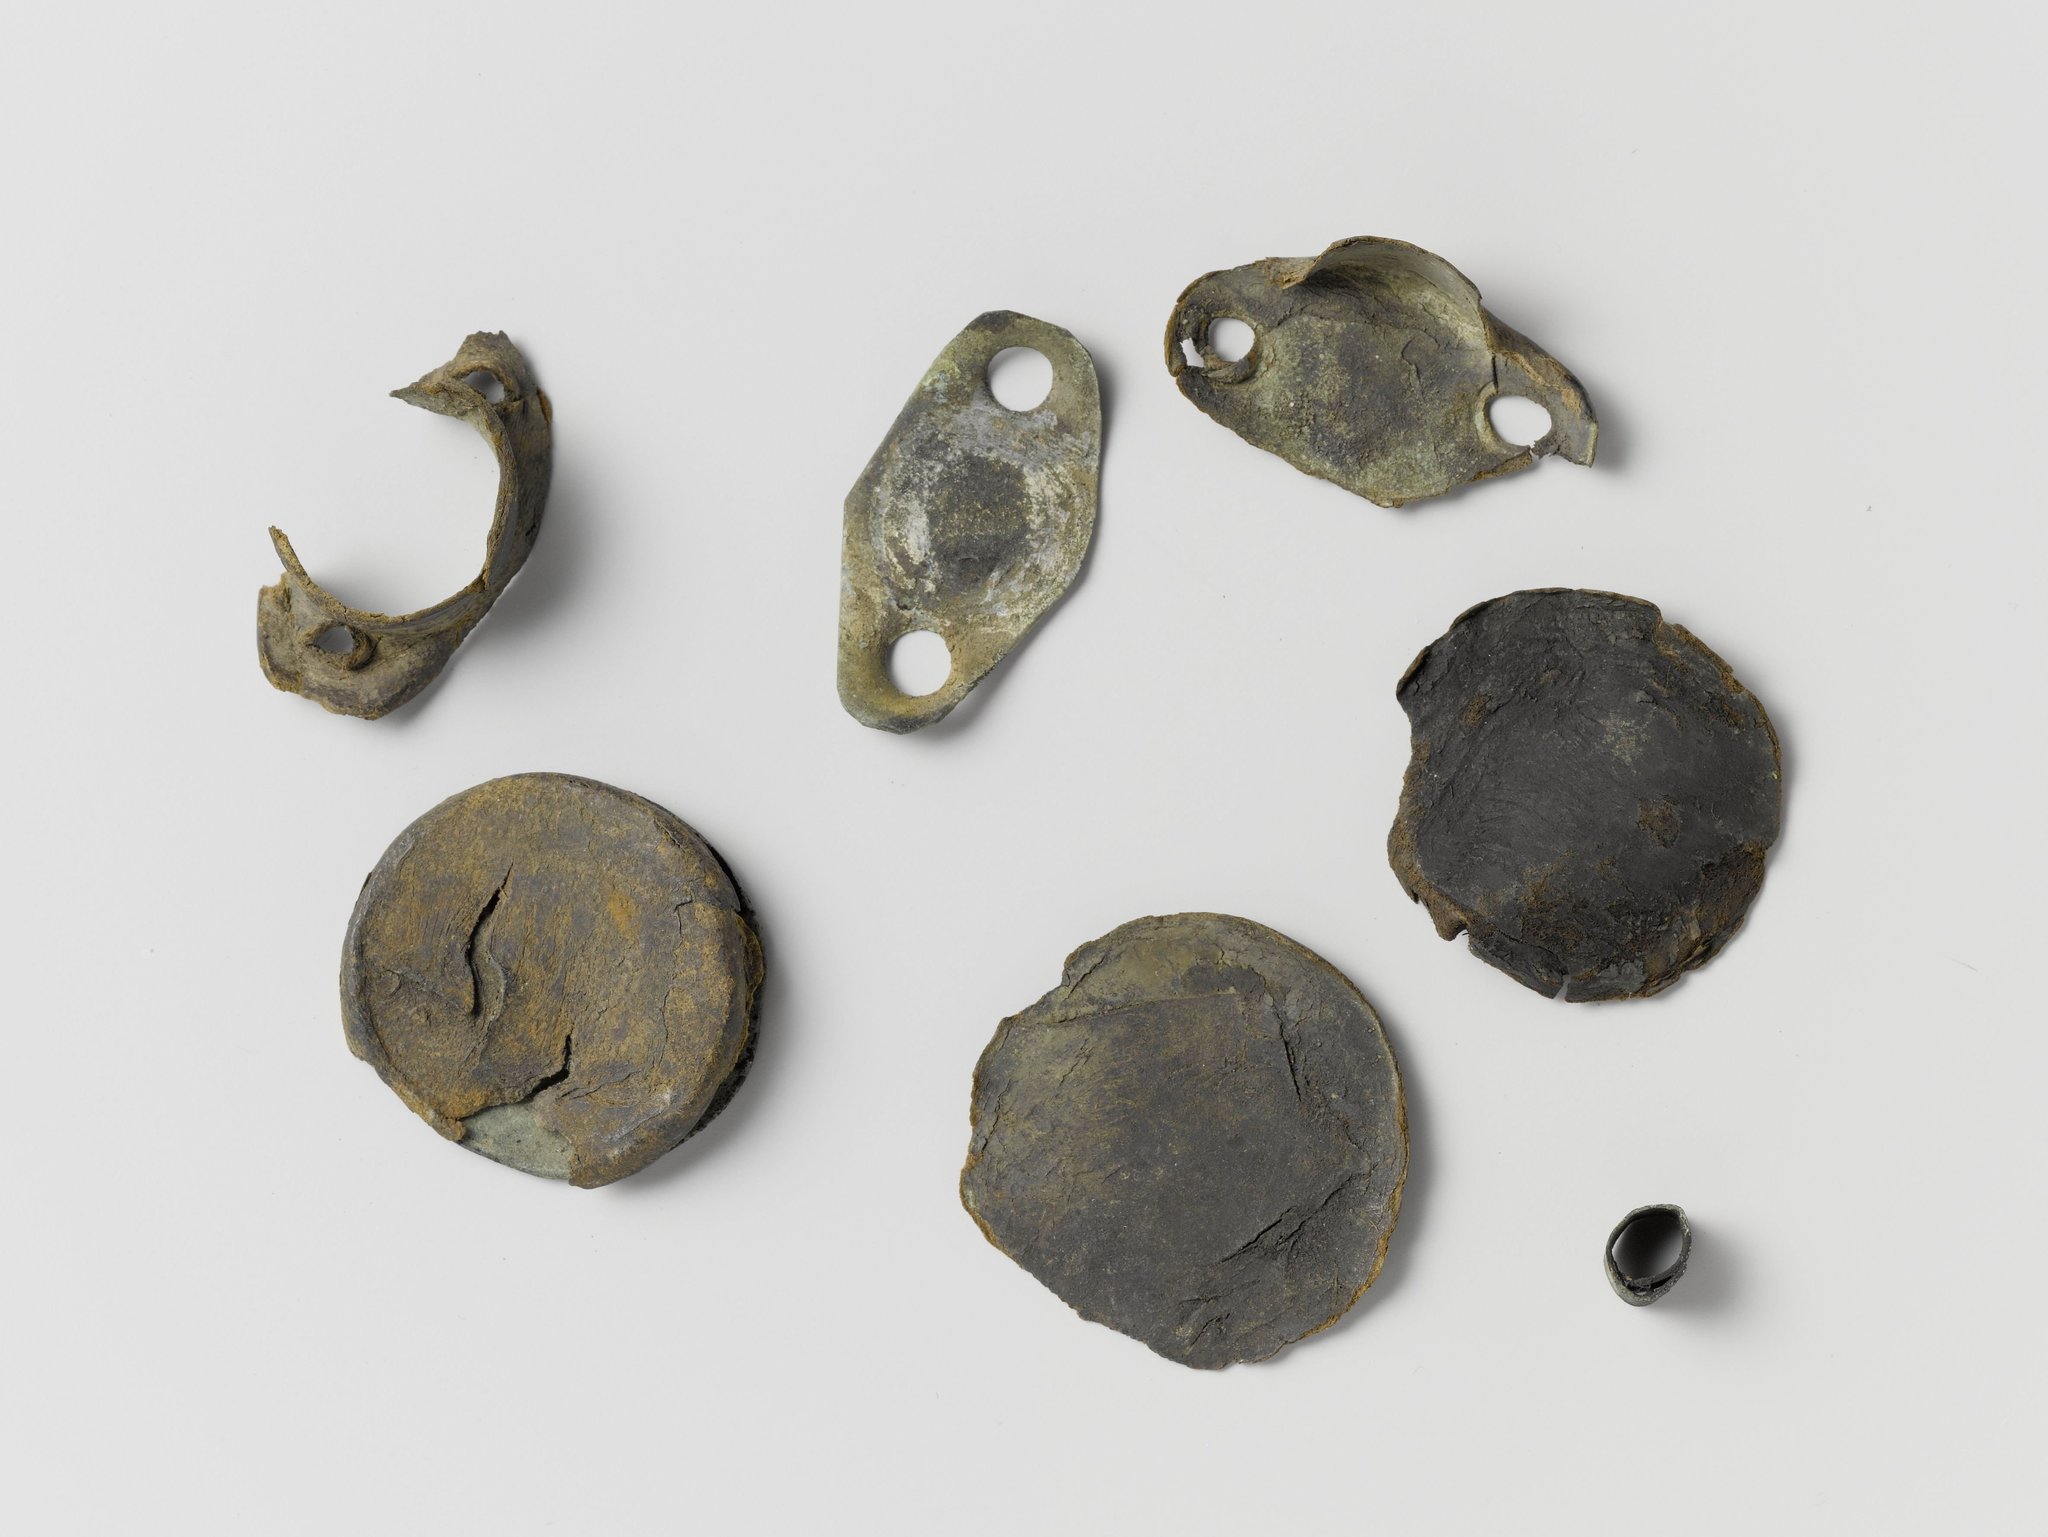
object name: kruitmaat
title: Fragmenten van musketmaten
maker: Anonymous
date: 1590-1596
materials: brass, leather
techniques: striking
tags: willem barendsz., amsterdam, jacob van heemskerck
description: Fragmenten van musketmaten waaronder een messing bodem (d.3.2), drie leren bodems (3.6, 3.6 en 3.5 cm), een stuk bovenkant van een leren deksel (3.7), een stuk hals van een leren deksel (3.5), een stuk van de bovenkant van een messing deksel (3.7) en een messing oortje (0.8 cm).